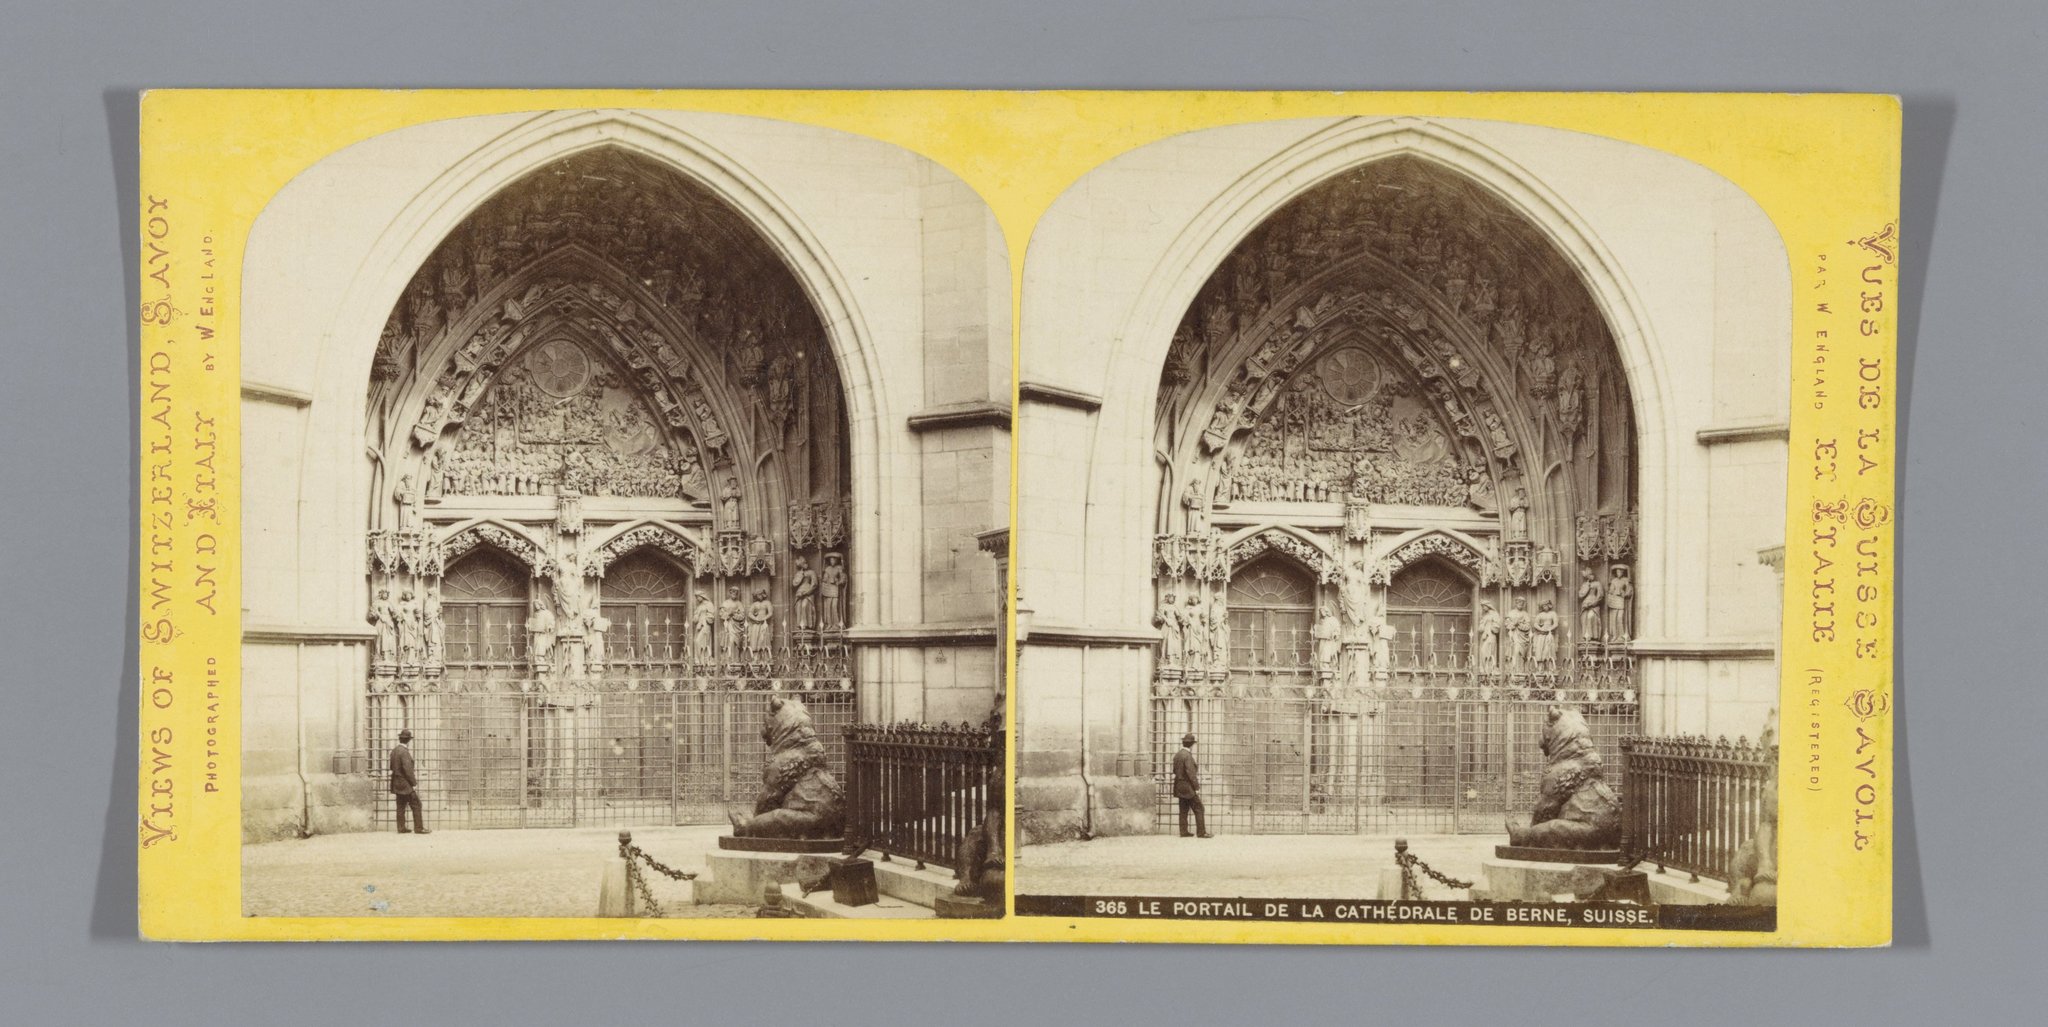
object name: stereograph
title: Le Portail de la Cath;edrale de Berne, Suisse.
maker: william england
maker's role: fotograaf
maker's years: 1816-1896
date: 1850-1880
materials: cardboard, photographic support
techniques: albumen print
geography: bern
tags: parts of church exterior and annexes: portal, bern minster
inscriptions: number: ‘365’, inscription: ‘Views of Switzerland, Savoy and Italy Photographed by W. England’